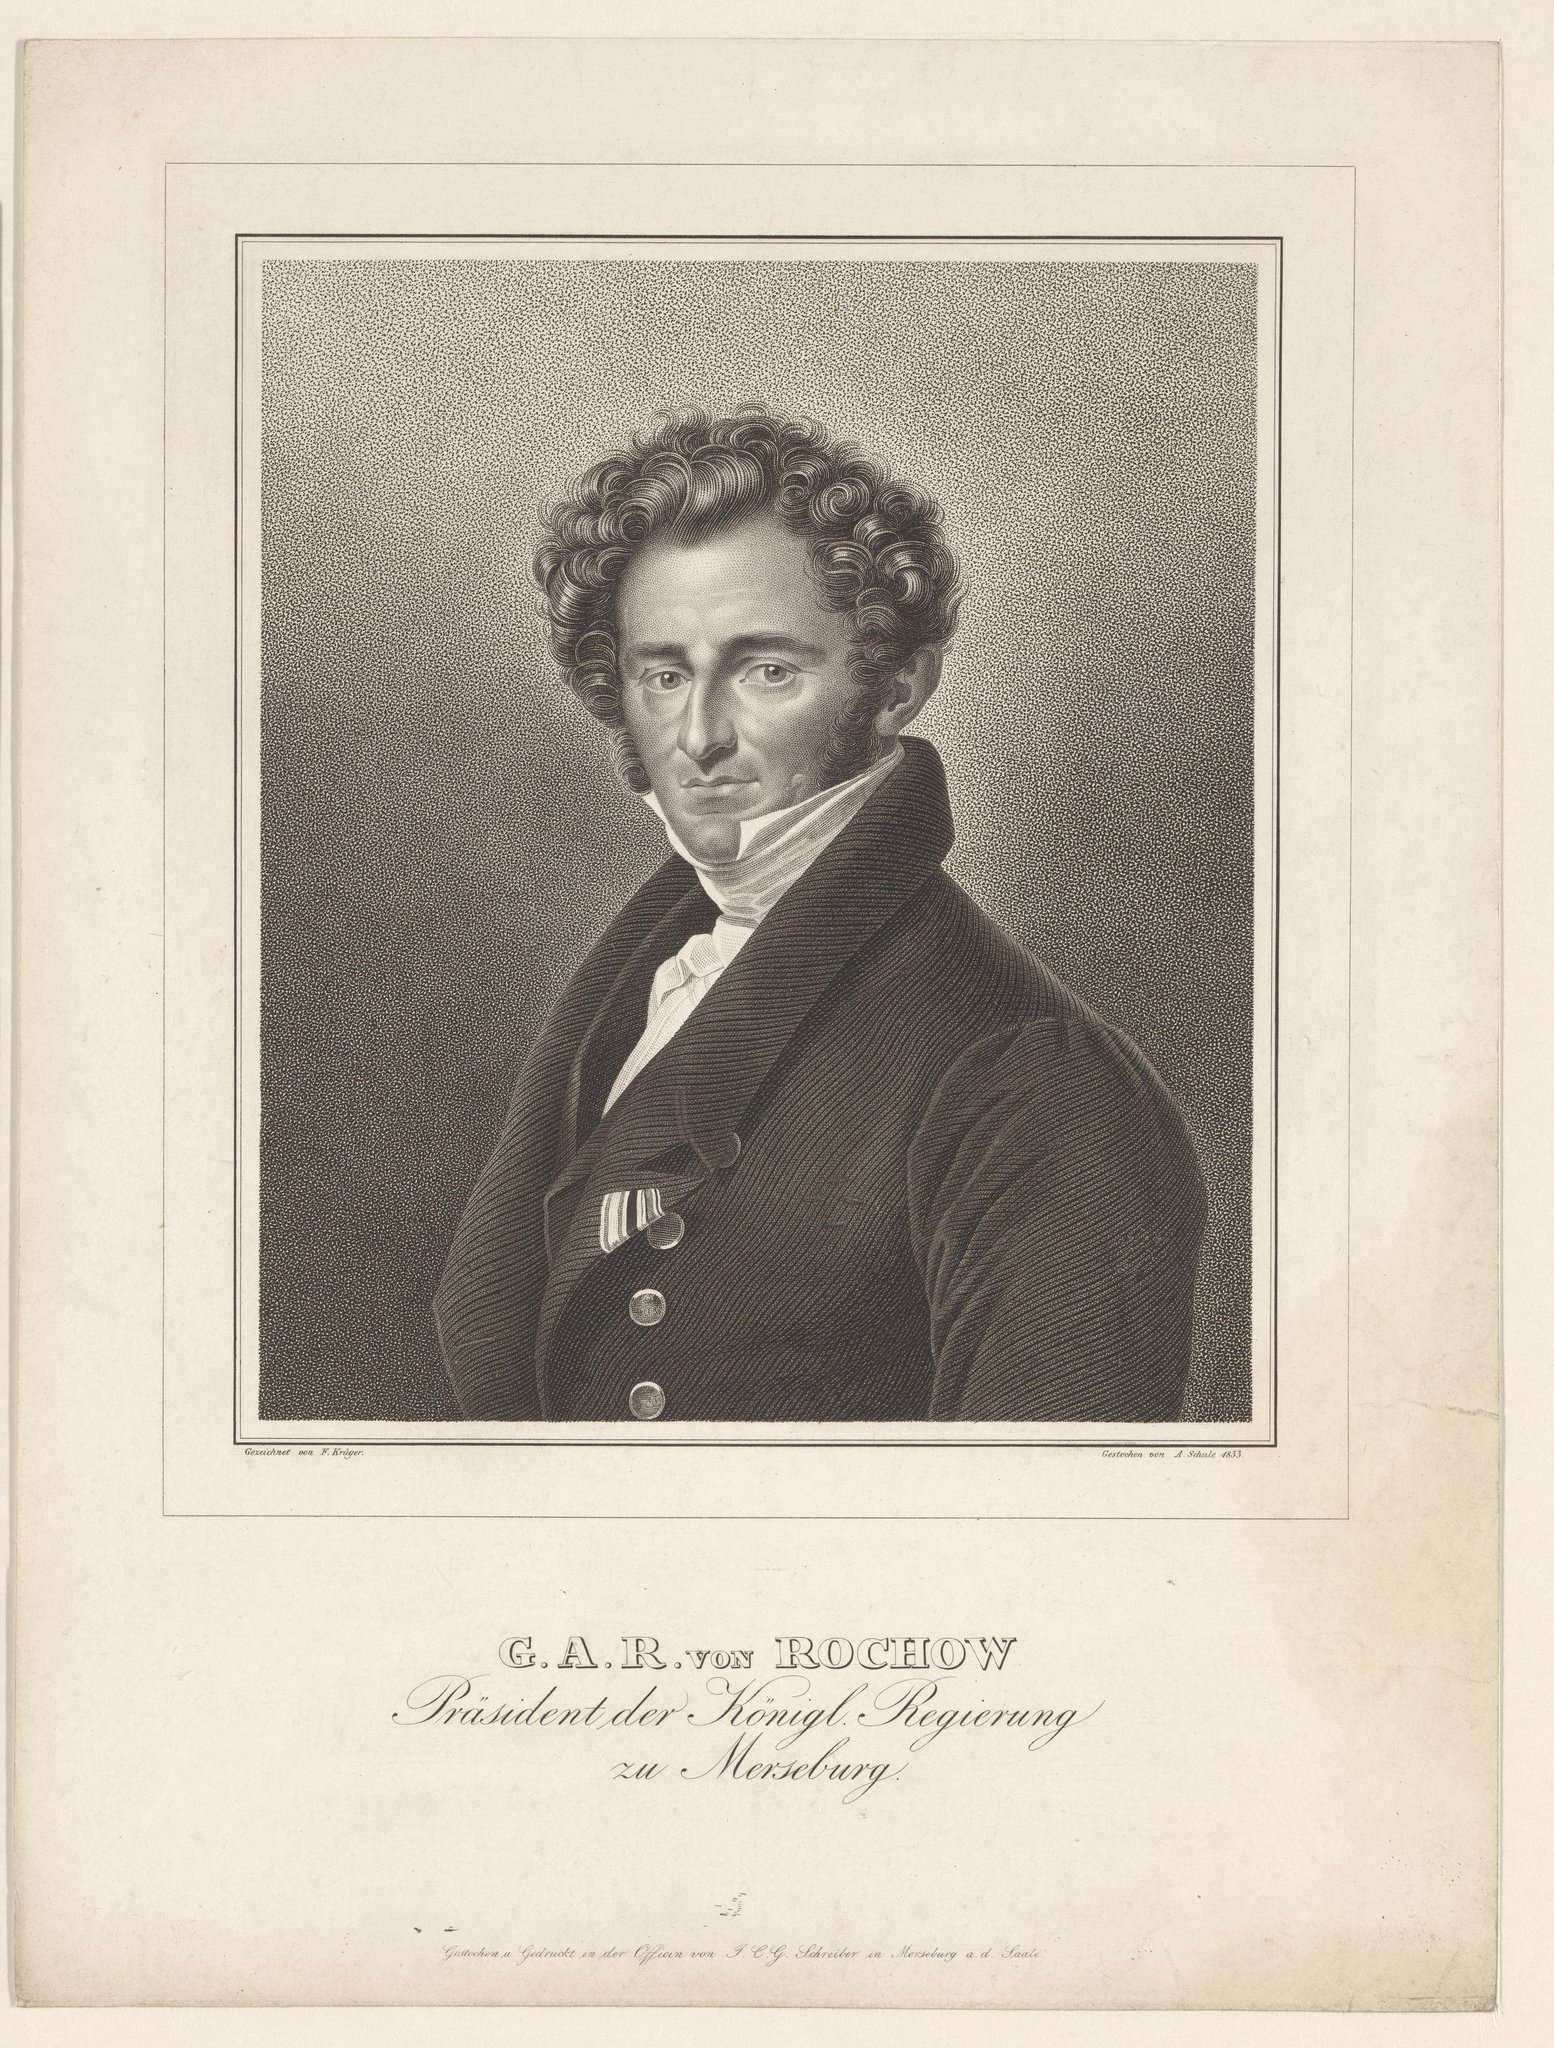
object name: print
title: Portret van Gustav Adolf von Rochow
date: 1833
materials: paper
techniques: engraving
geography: merseburg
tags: historical persons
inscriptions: collector's mark: Lugt 2228